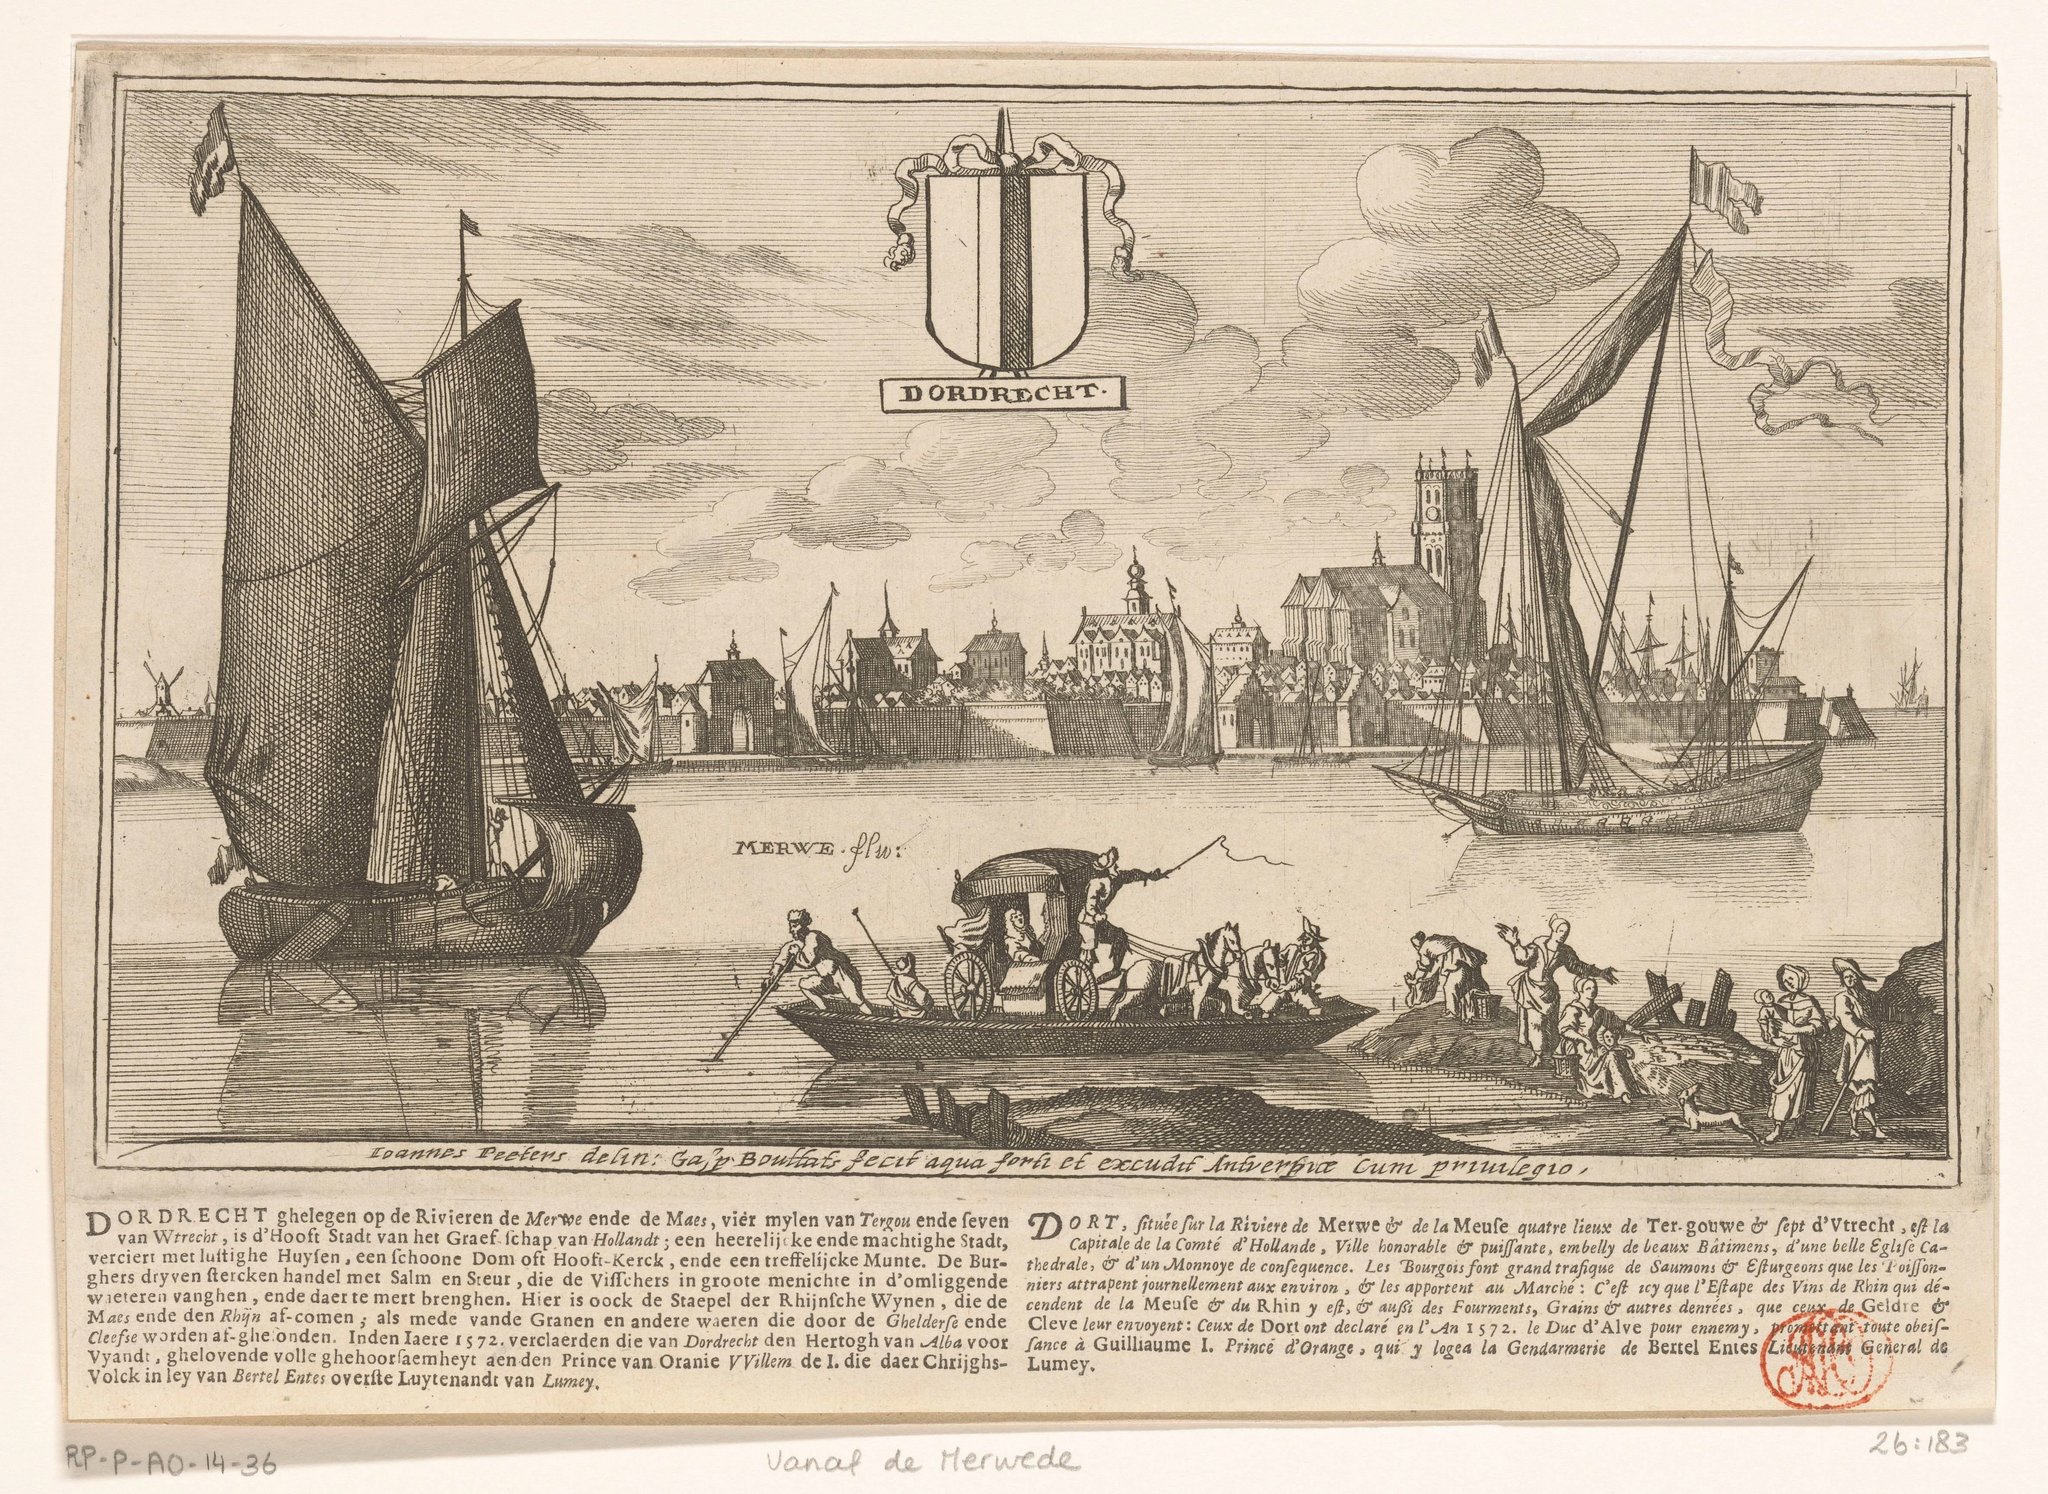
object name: print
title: Dordrecht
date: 1675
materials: paper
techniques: etching, letterpress printing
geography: antwerp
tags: coat of arms (as symbol of the state, etc.) (+ city; municipal), prospect of city, town panorama, silhouette of city, dordrecht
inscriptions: collector's mark: Lugt 195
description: Gezicht op Dordrecht, gezien vanaf het water. In het water verschillende schepen. Rechts op de achtergrond de Grote of Onze-Lieve-Vrouwekerk. Boven in het midden het stadswapen en de titel. Onder de afbeelding een beschrijving van de stad in het Nederlands en in het Frans.